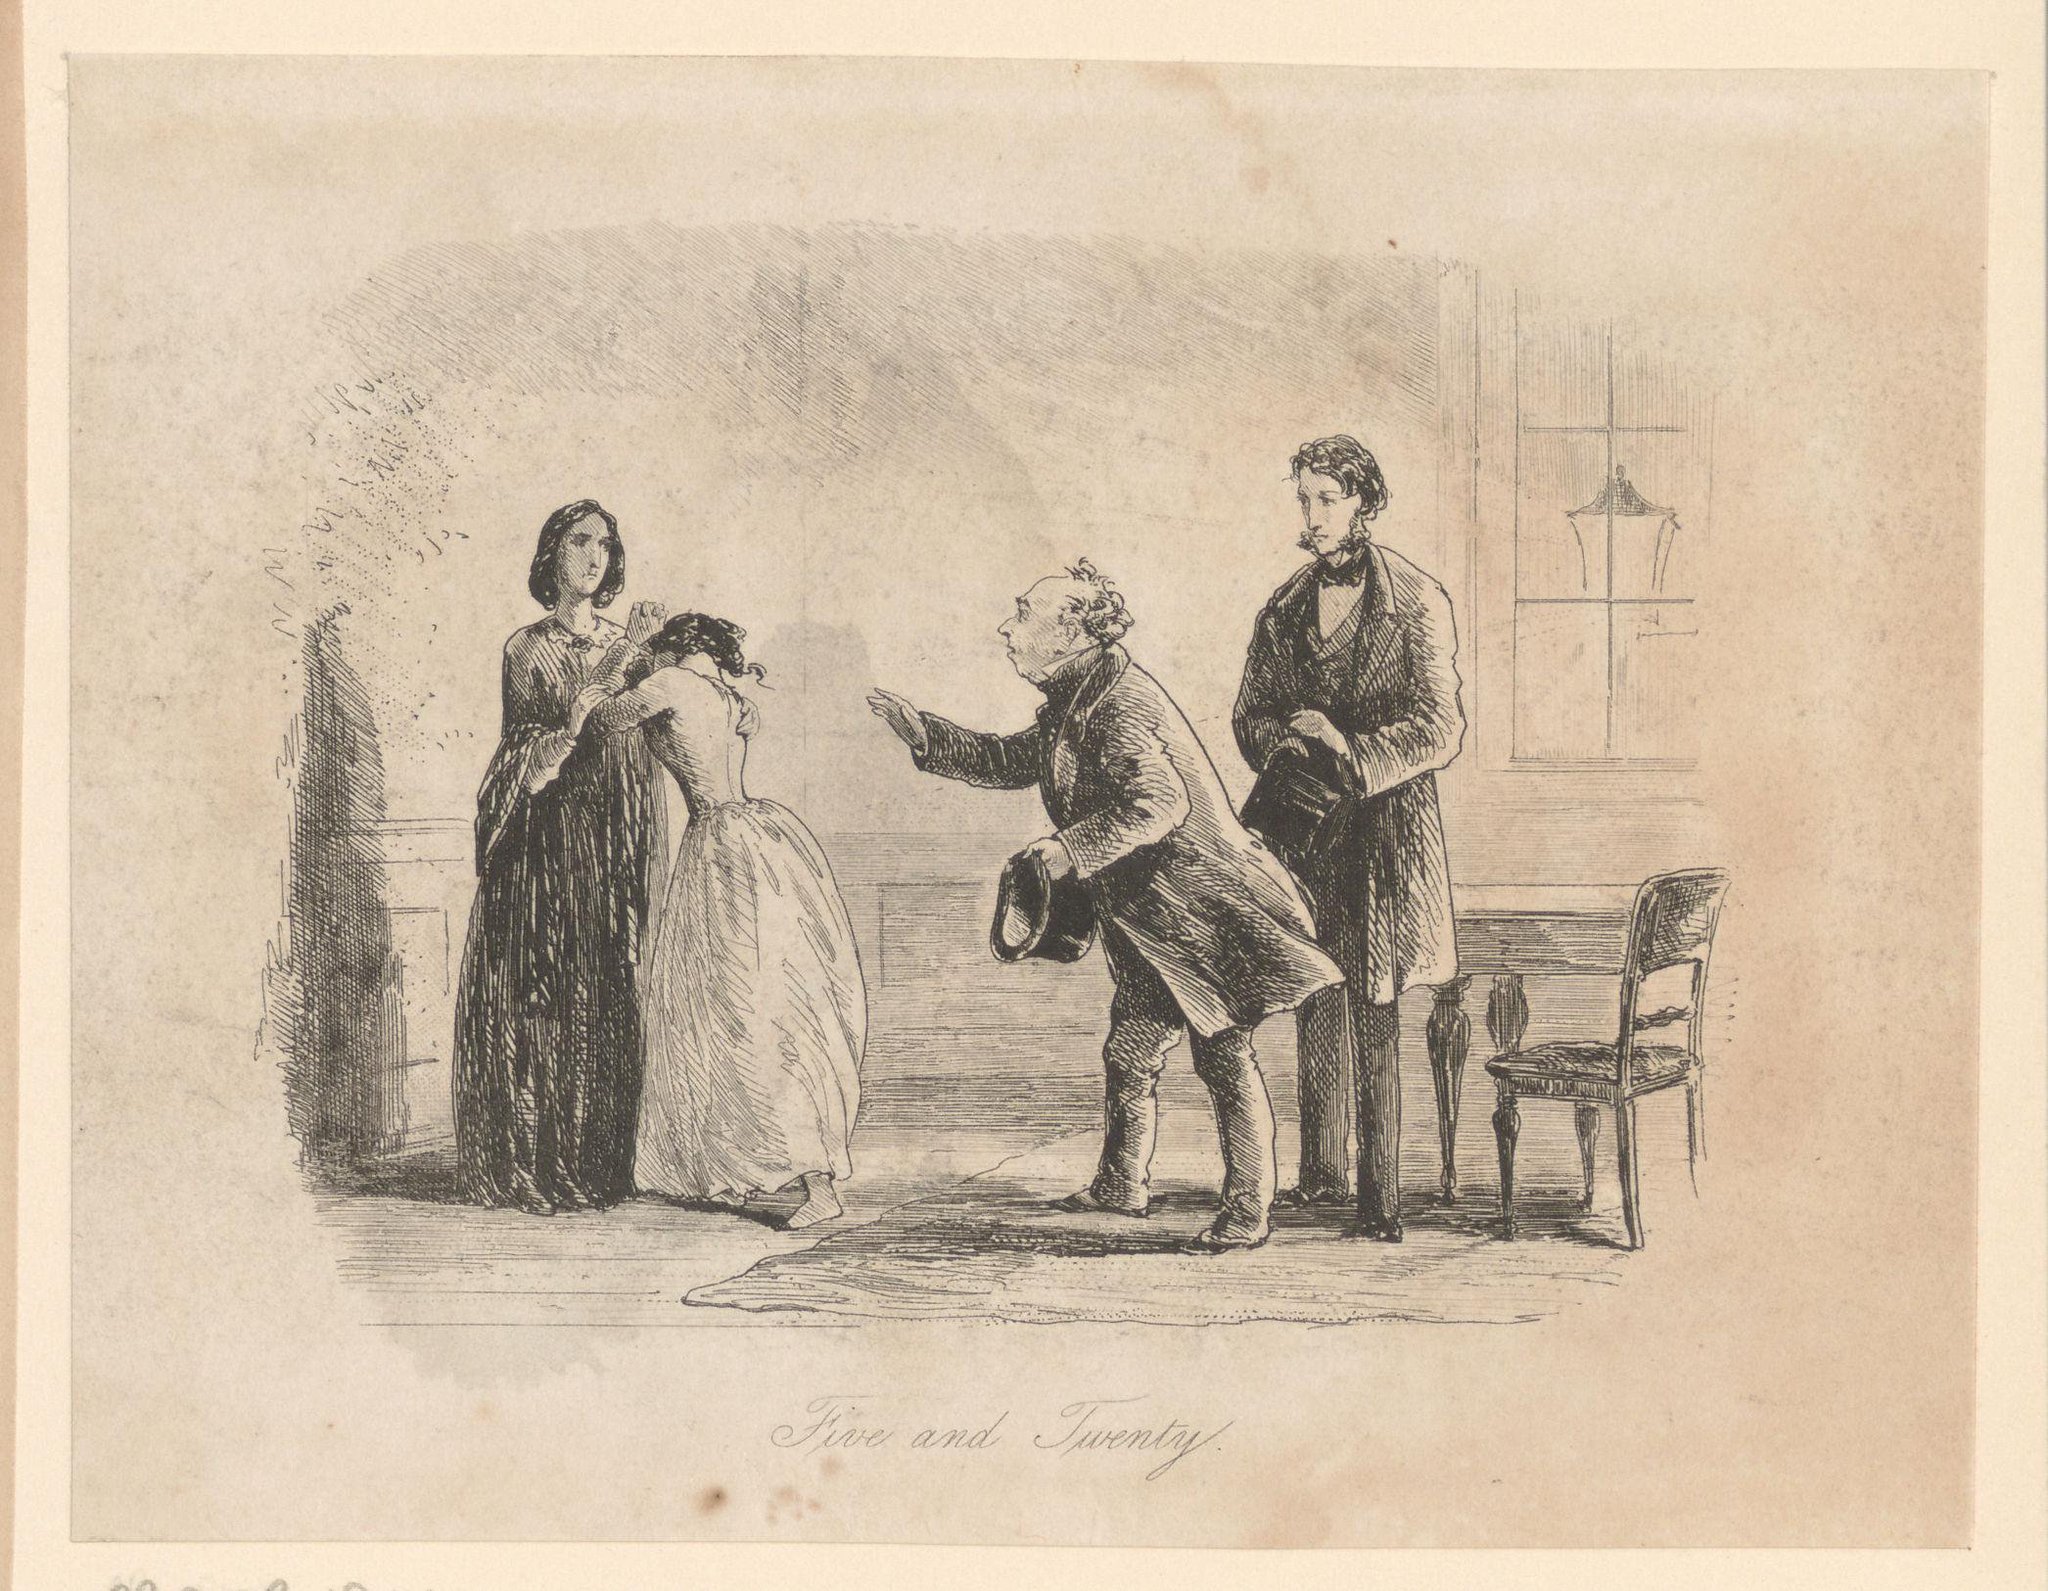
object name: book illustration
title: Meneer Meagles probeert Tattycoram te overtuigen mee te gaan, maar zij keert zich naar Miss Wade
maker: hablot knight browne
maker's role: print maker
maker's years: 1815-1882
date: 1807-1856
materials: paper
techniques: etching, roulette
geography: london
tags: reaching for something, gripping someone by the arm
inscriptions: collector's mark: Lugt 2228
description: Prent uit: Dickens, Charles. Little Dorrit. Londen: Bradbury & Evans, 1857. Het boek werd tussen 1855 en 1857 eerst in delen uitgegeven. Deze prent werd voor het eerst uitgegeven in juli 1856.